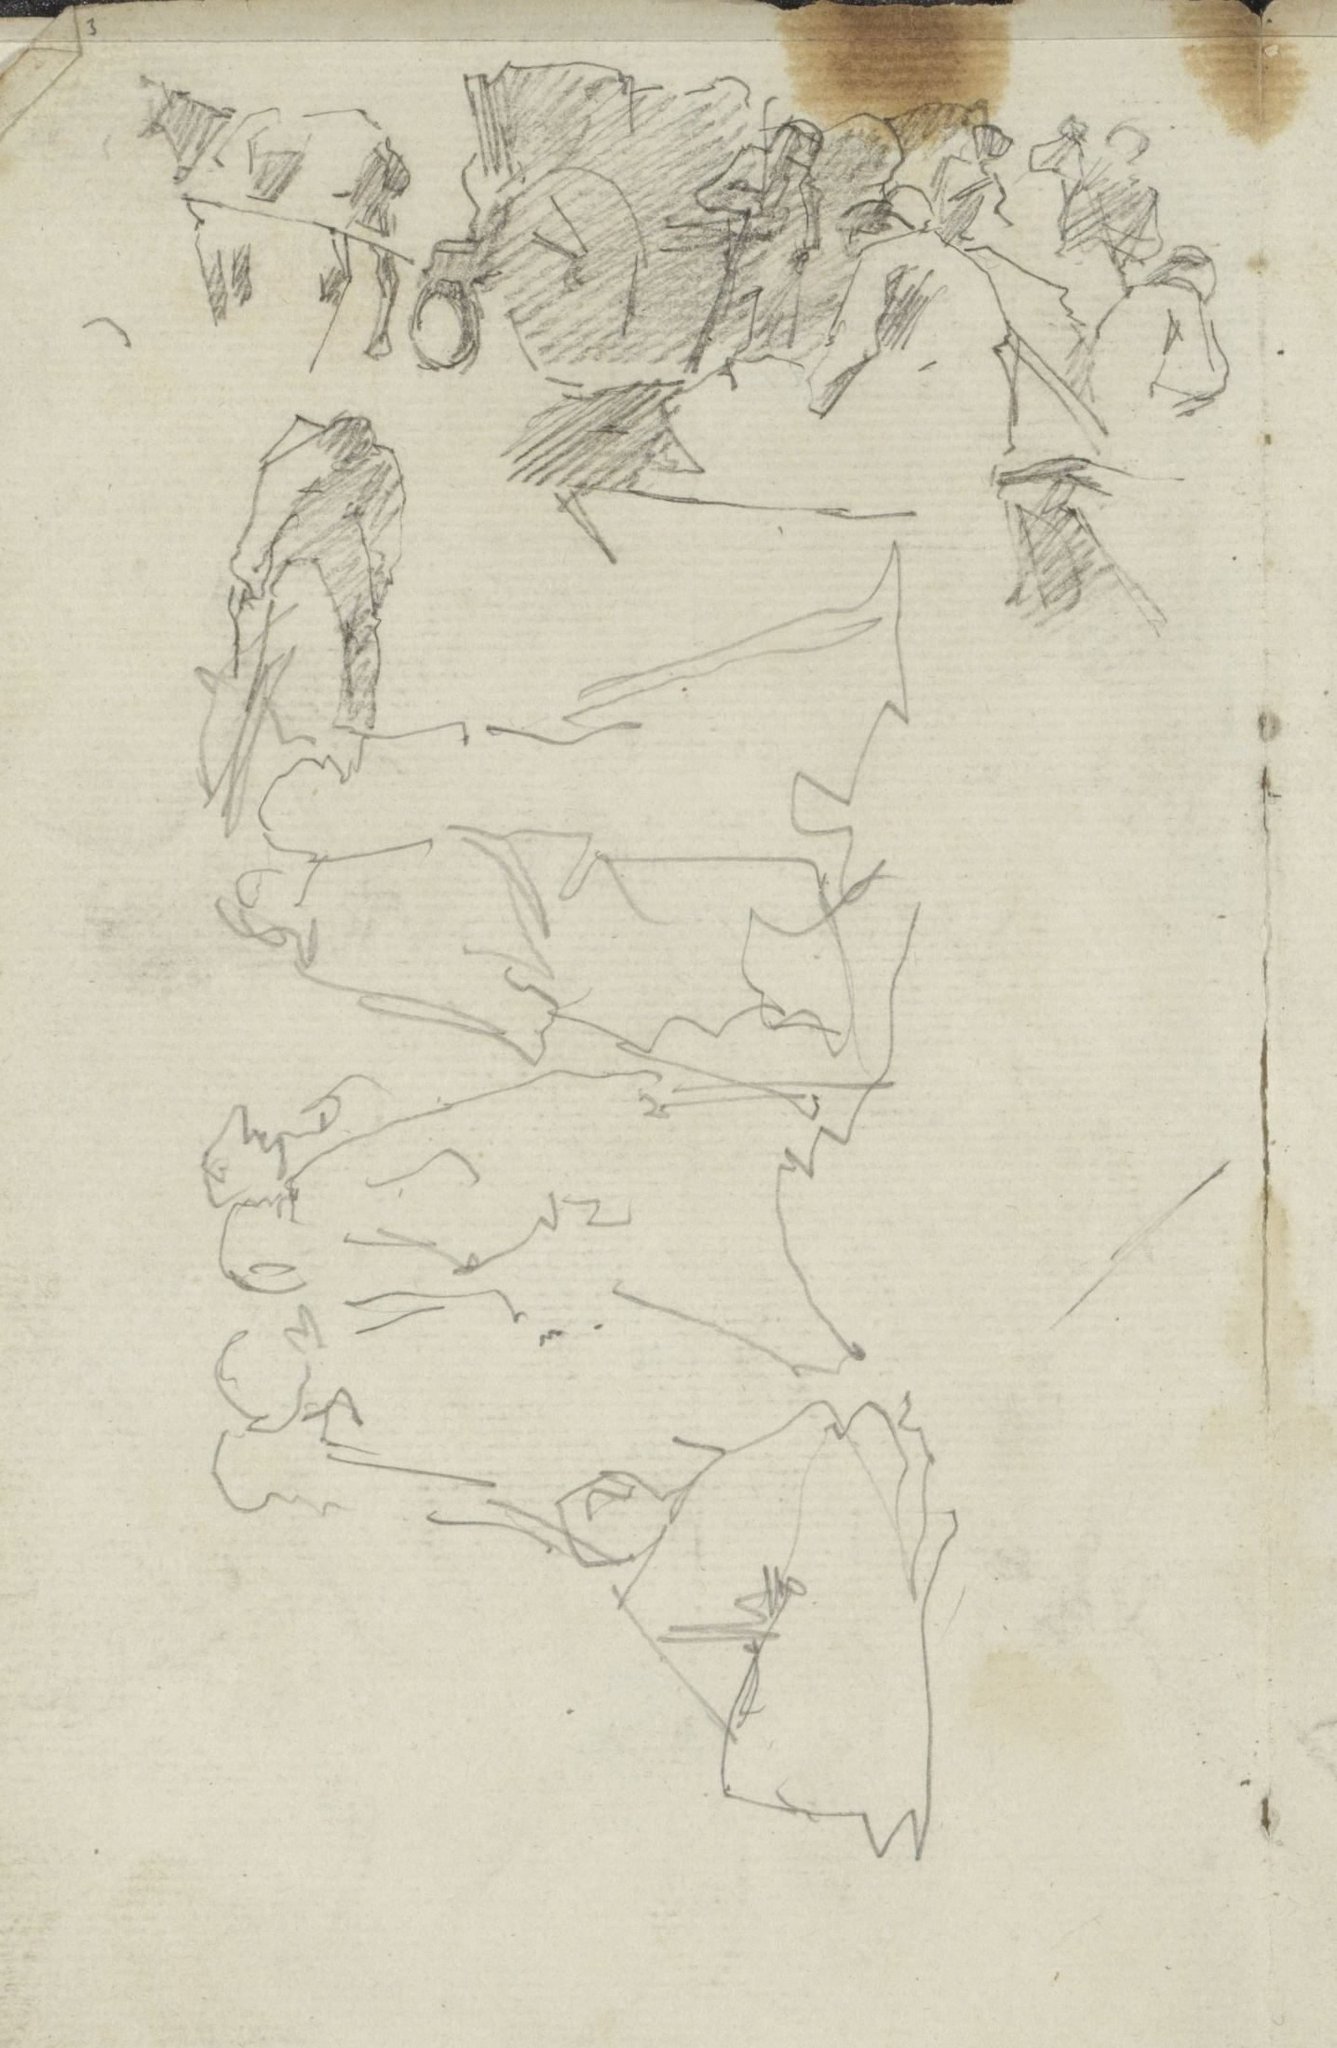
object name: sketchbook leaf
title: Groepen figuren en een paard-en-wagen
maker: george hendrik breitner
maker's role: draughtsman, painter, print maker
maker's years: 1857-1923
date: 1880-1882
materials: chalk, paper, pencil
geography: the hague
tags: four-wheeled vehicle drawn by one animal, adult woman, adult man, (farm) wagon, freight wagon, cart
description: Pagina 3 uit een schetsboek met 25 bladen.